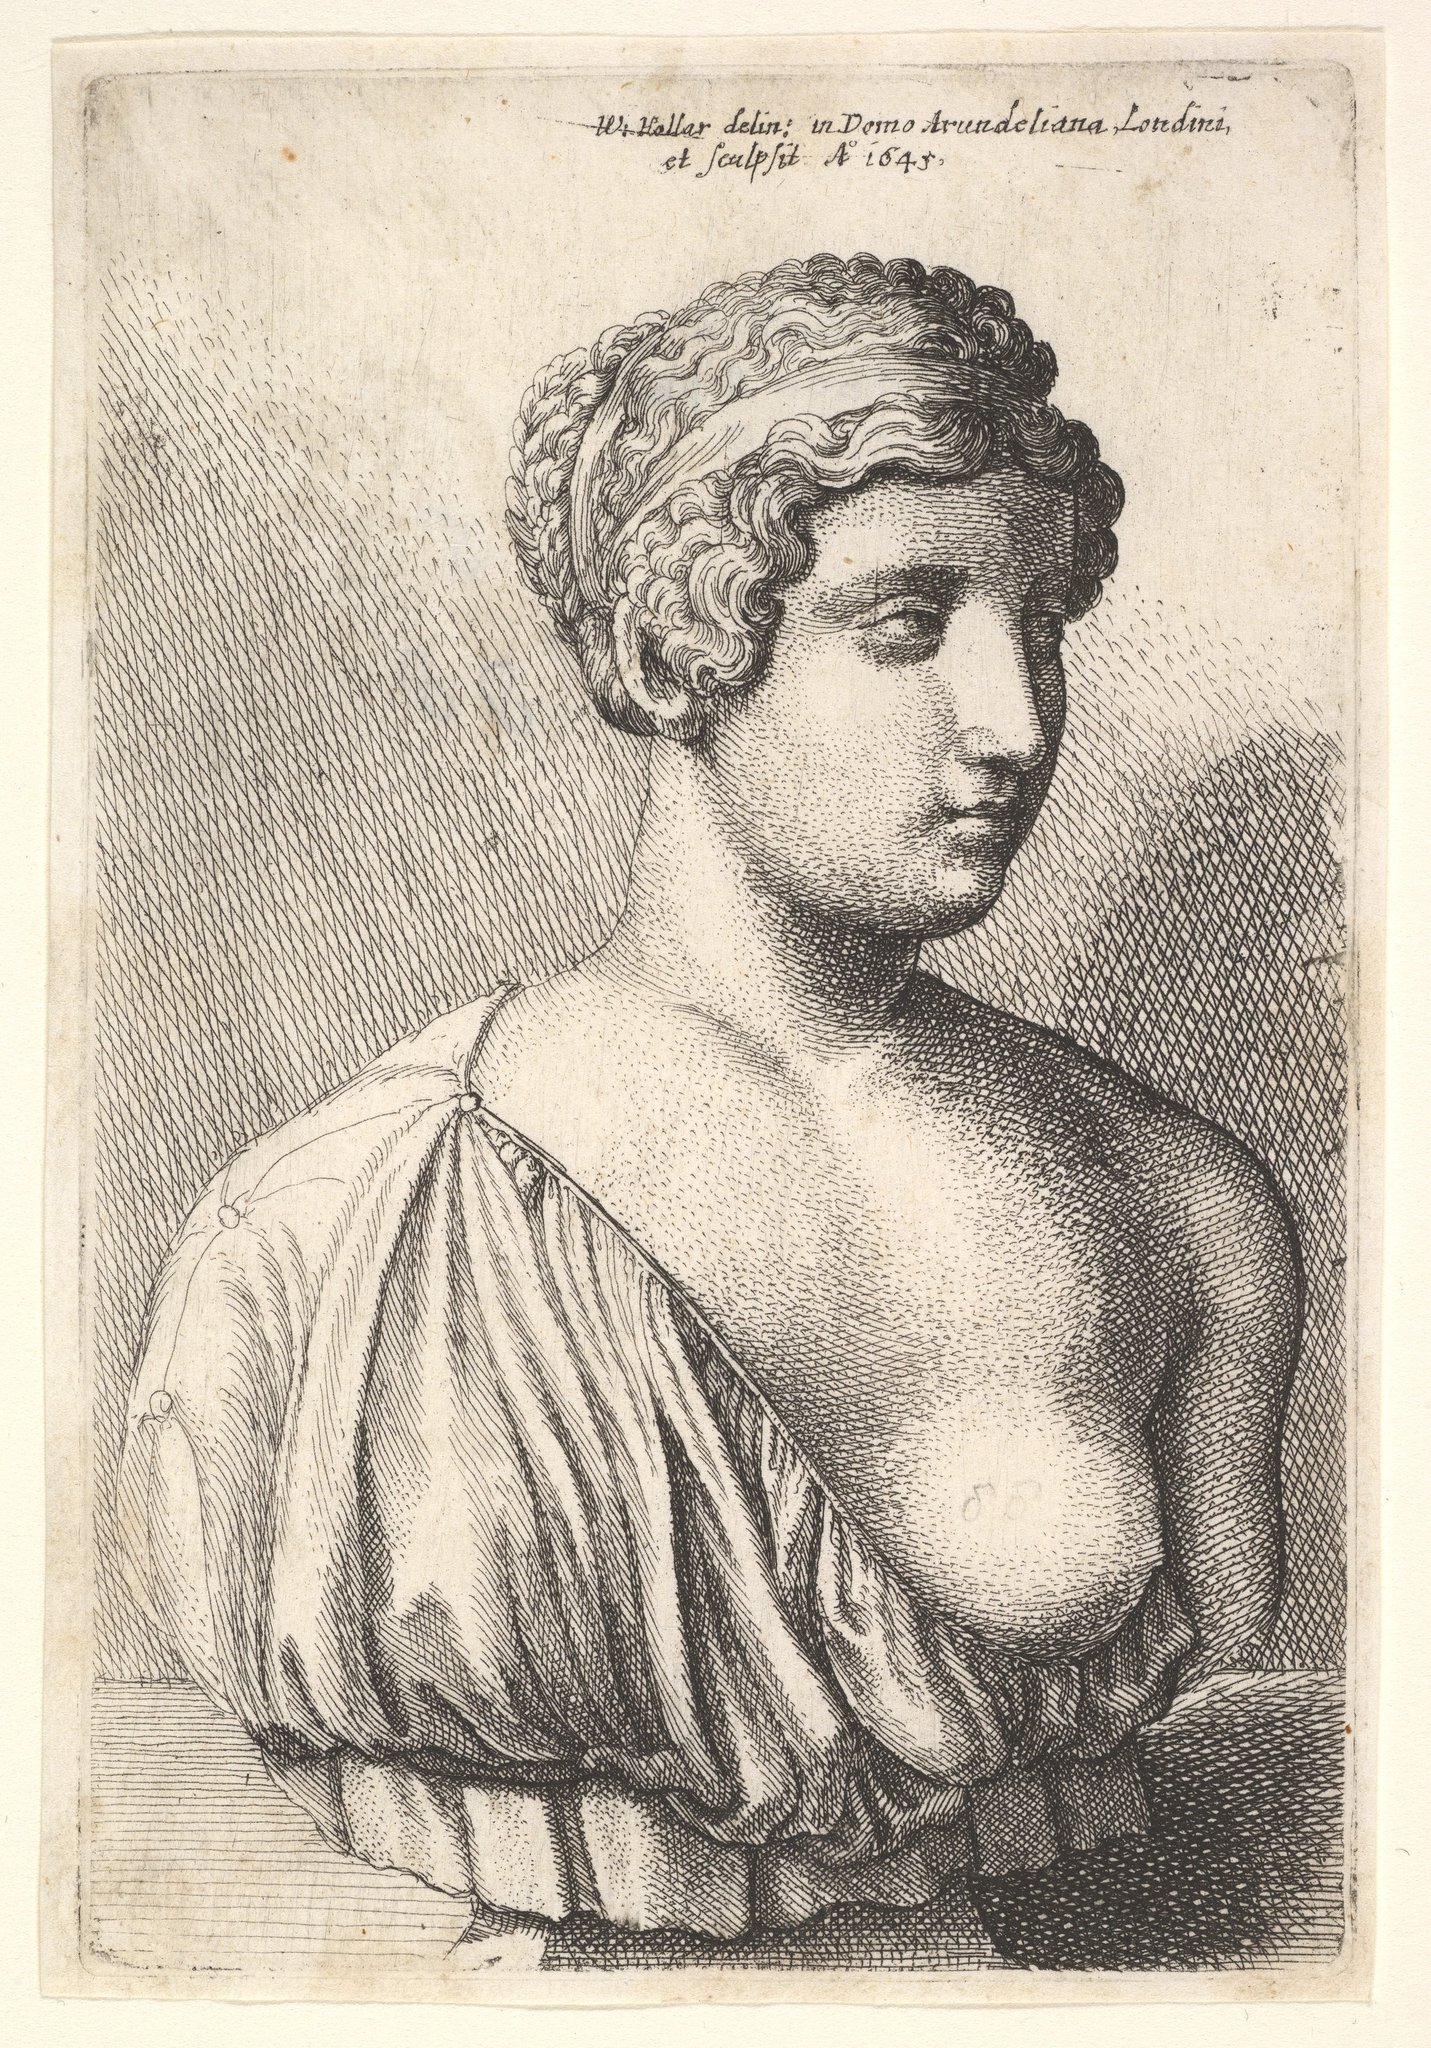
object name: print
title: Antique bust of a woman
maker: wenceslaus hollar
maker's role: artist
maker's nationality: bohemian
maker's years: 1607-1677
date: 1645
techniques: etching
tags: portraits,female nudes